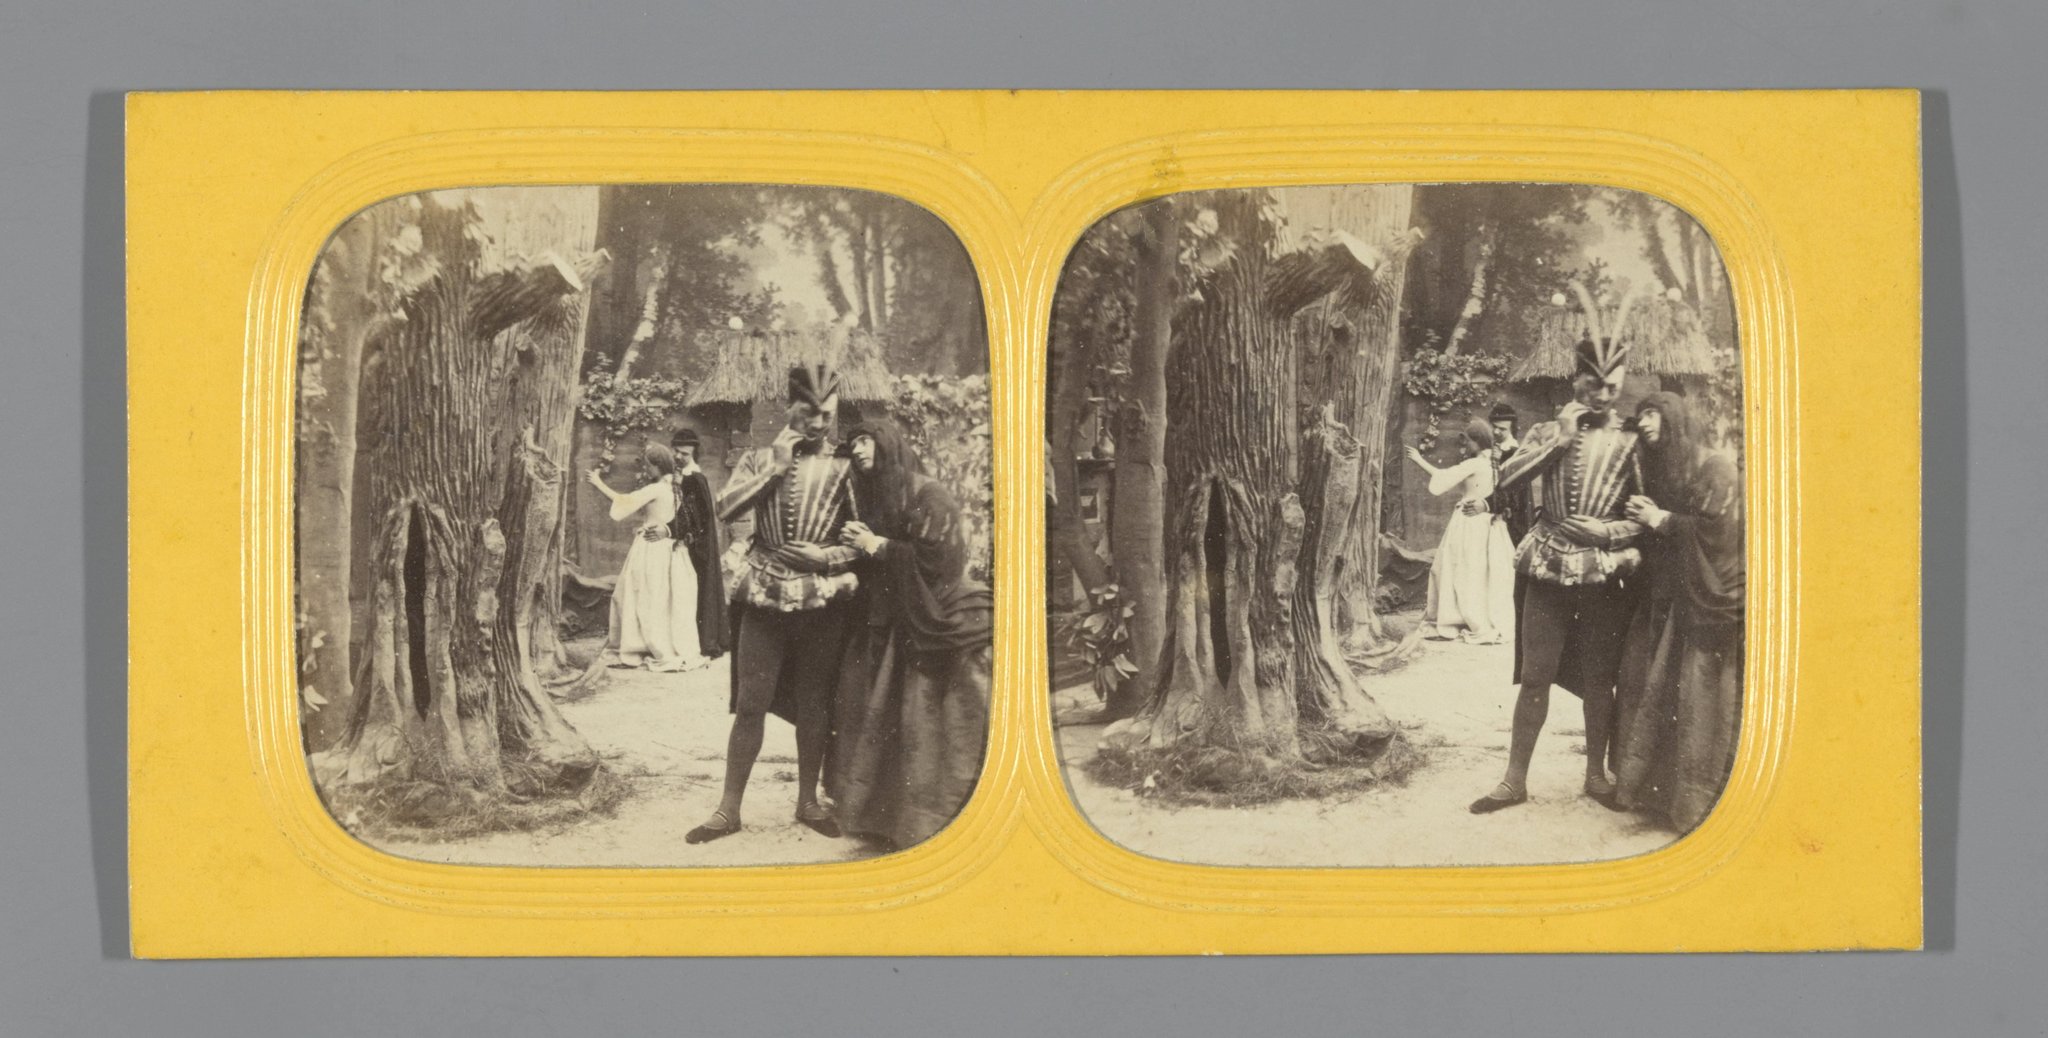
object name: tissue stereograph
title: Scène uit Faust: twee wandelende paren in een bos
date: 1868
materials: cardboard, paper, photographic support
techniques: albumen print, cutting, hand coloring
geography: paris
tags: couple of lovers